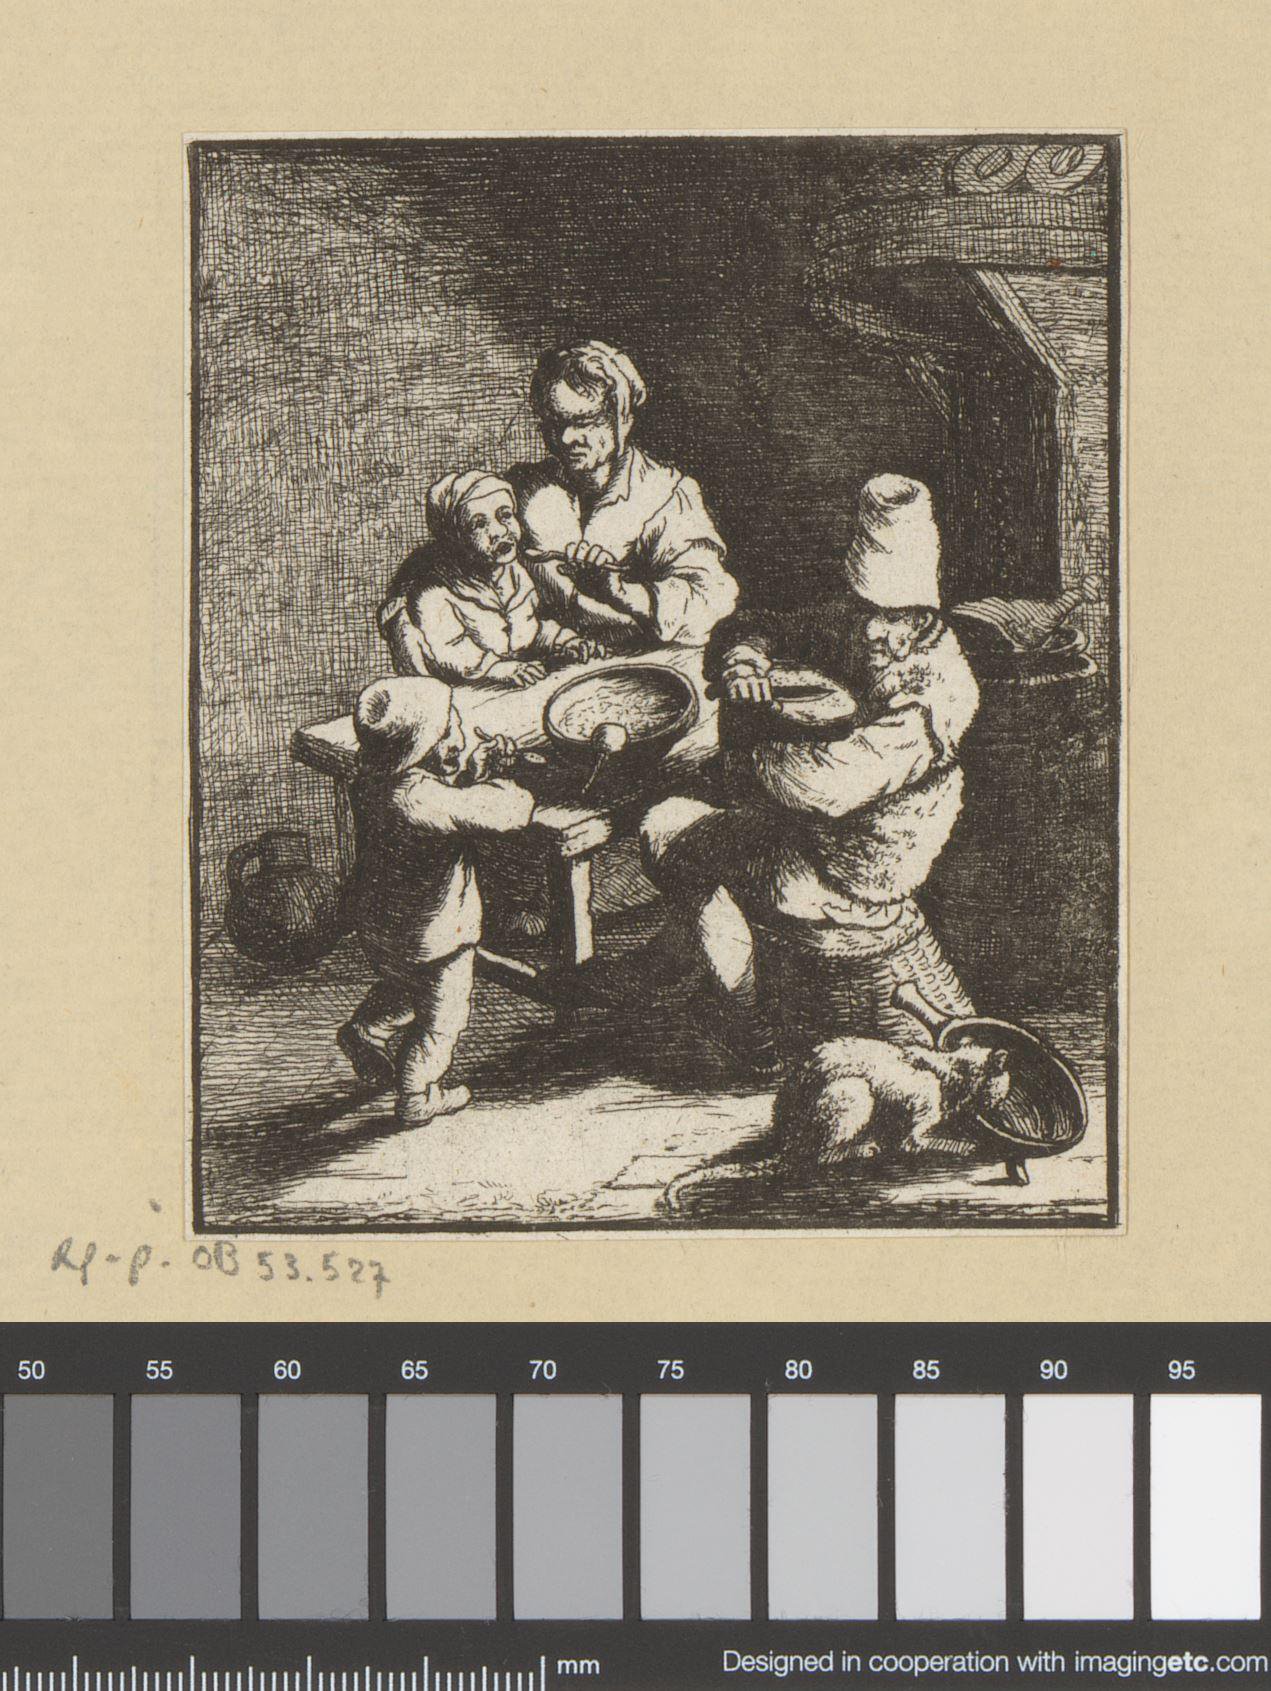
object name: print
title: Gezin etend aan tafel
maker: carl august grossmann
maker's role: print maker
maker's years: 1741-1798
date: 1760-1798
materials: paper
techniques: etching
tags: (family) meal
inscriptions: collector's mark: Lugt 240